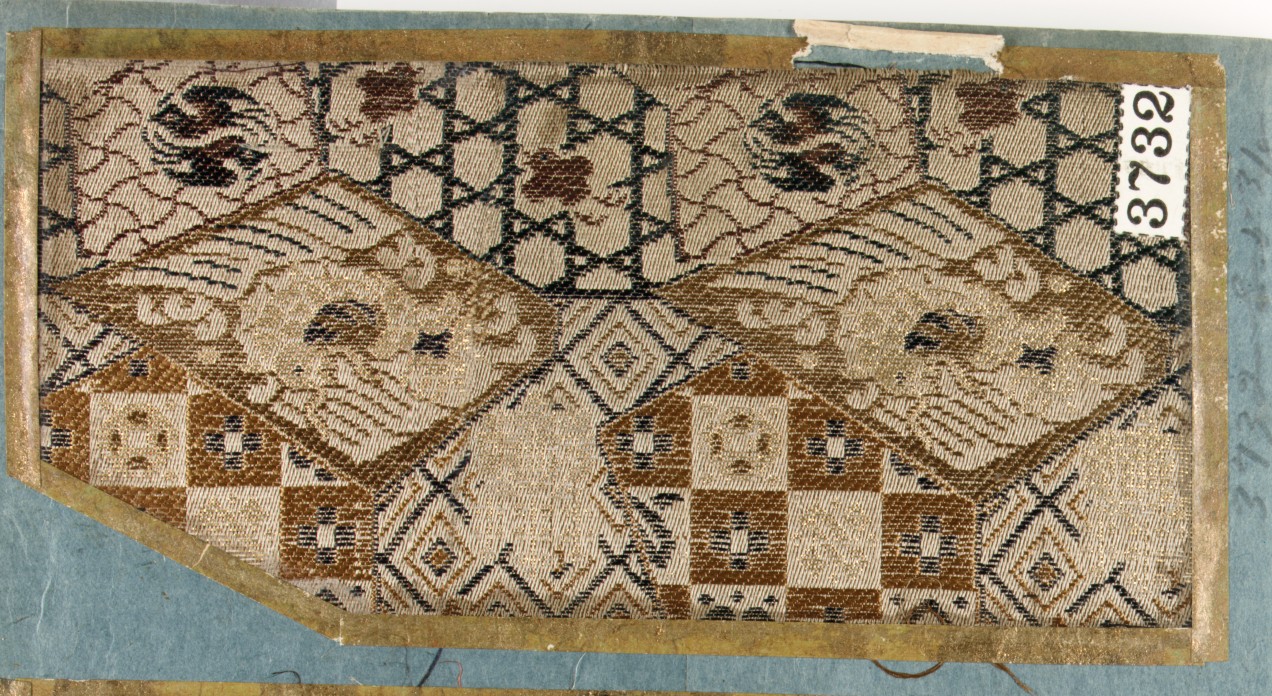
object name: sample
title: Textile Sample from Sample Book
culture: japanese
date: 1801-1900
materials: silk